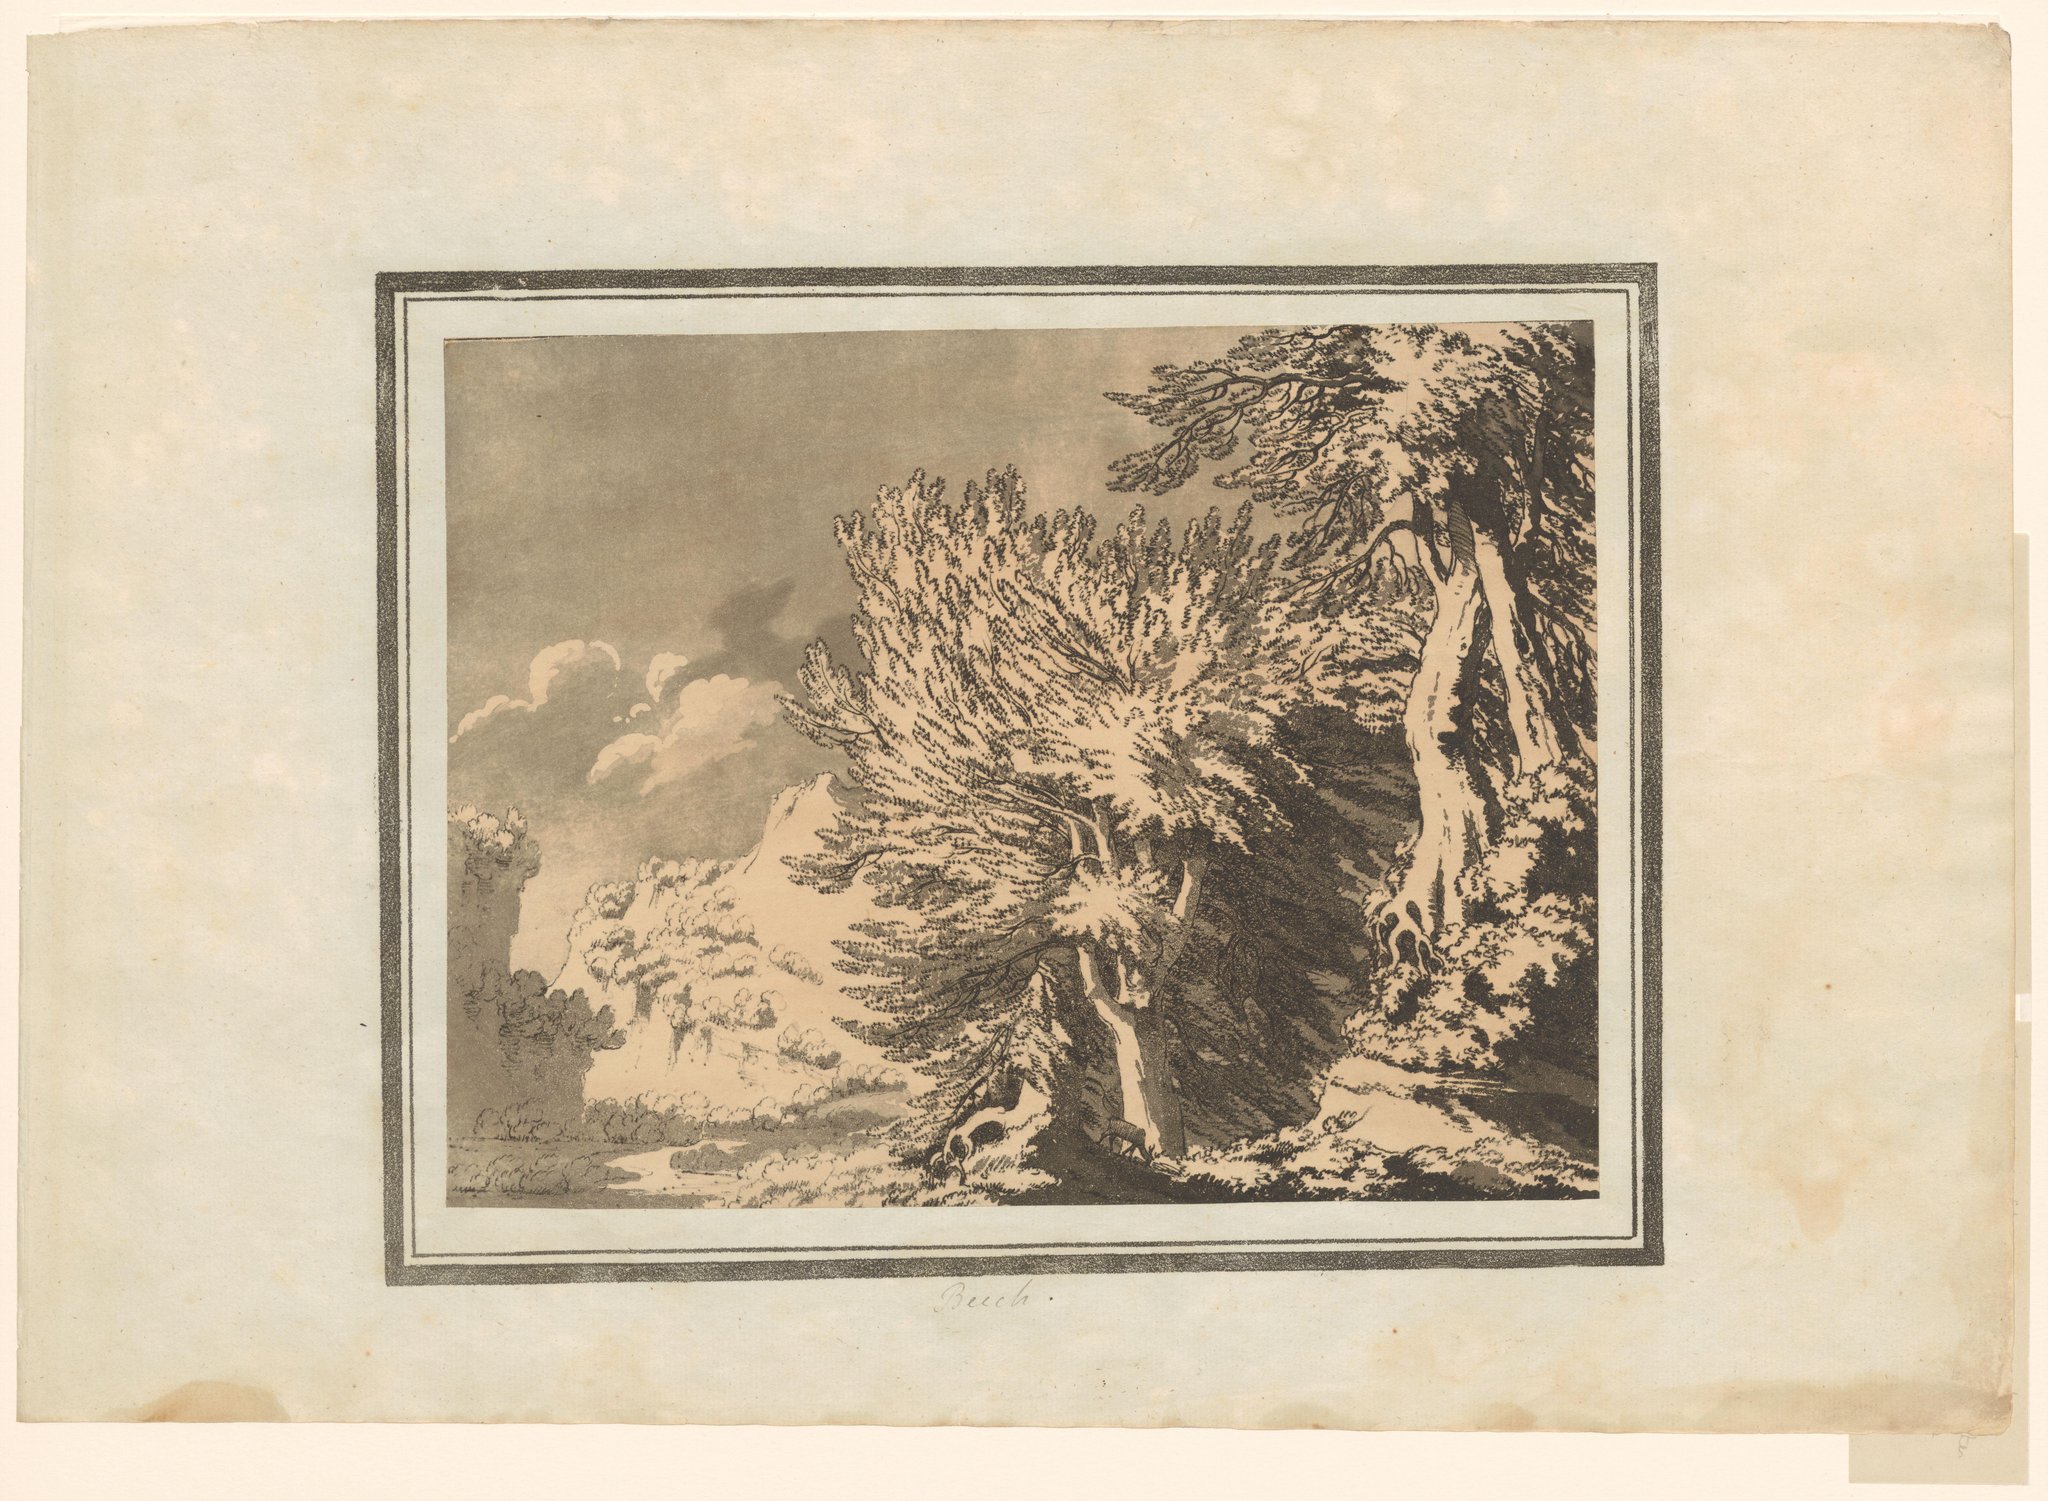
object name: print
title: Beech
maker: john robert cozens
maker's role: draughtsman, print maker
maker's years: 1752-1797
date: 1789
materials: paper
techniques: aquatint, soft ground etching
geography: london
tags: trees: beech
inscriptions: title: ‘Beech.’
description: Cozens wrote ‘Beech’ in pen below this print of a group of trees. The surrounding landscape and the deer grazing in the copse suggest that Cozens sketched the scene somewhere in Britain rather than southern Europe.